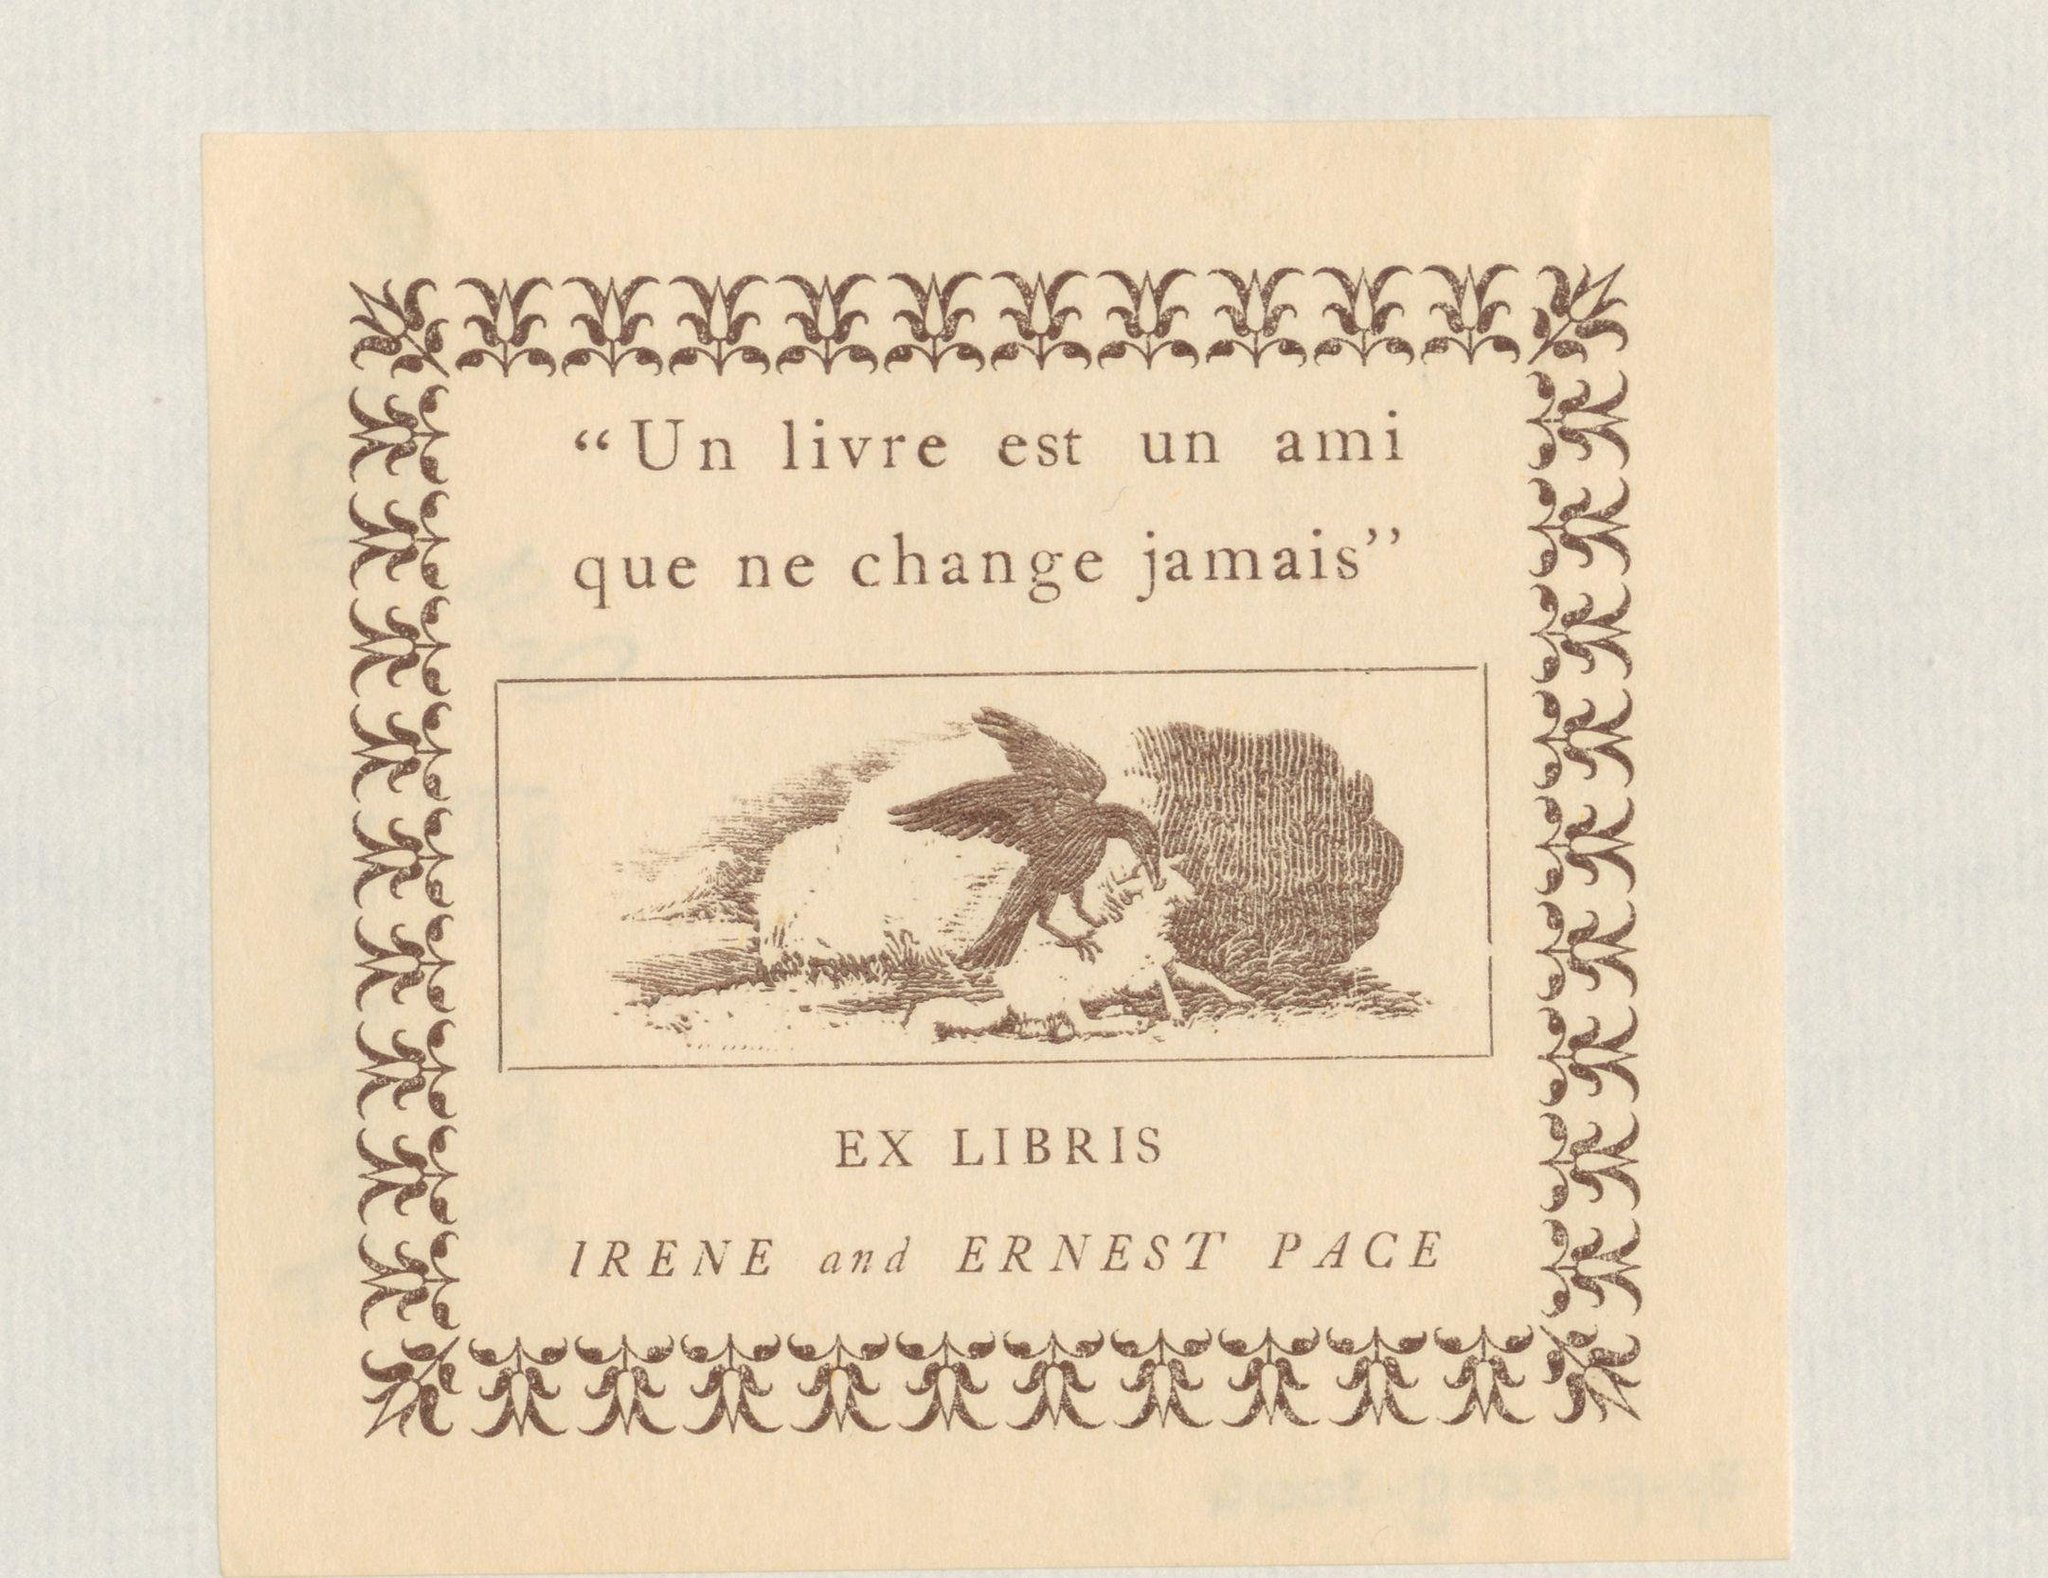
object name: bookplate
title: Ex libris van Irene and Ernest Pace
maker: thomas bewick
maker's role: draughtsman, painter, print maker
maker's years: 1753-1828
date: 1790-1828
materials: paper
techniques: letterpress printing, engraving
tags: predatory birds, lamb